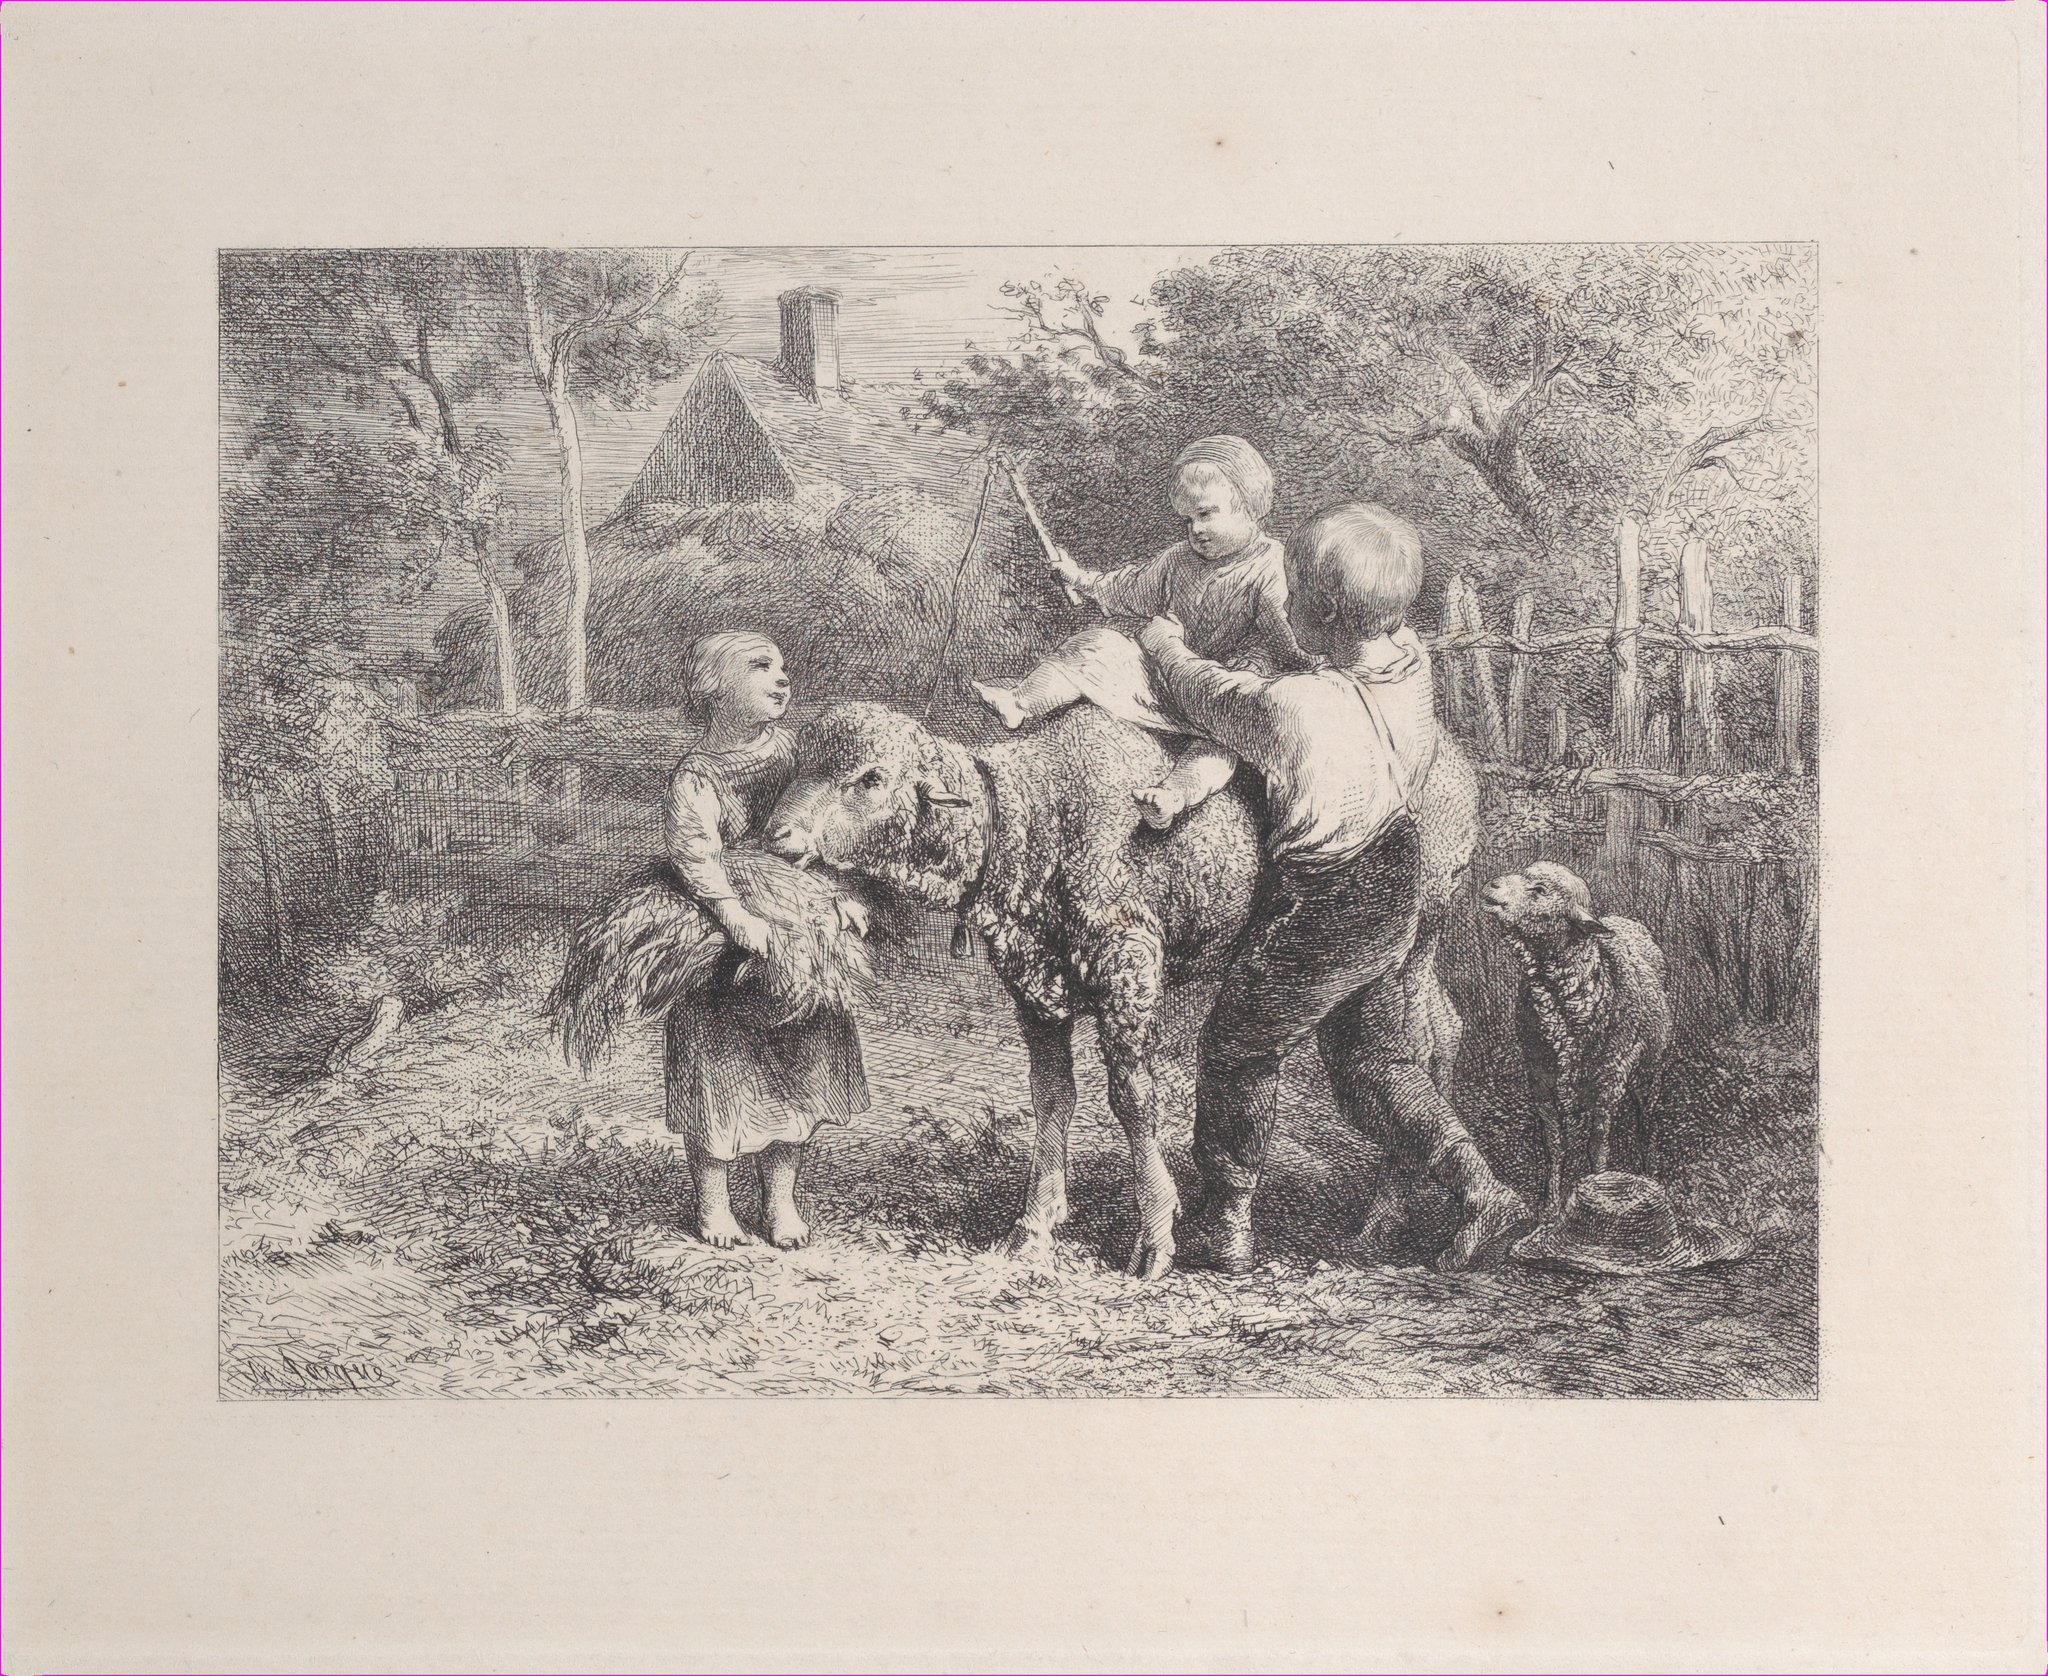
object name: print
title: First Riding Lesson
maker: charles émile jacque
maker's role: artist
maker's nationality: french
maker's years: 1813-1894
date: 1864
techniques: etching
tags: children,sheep